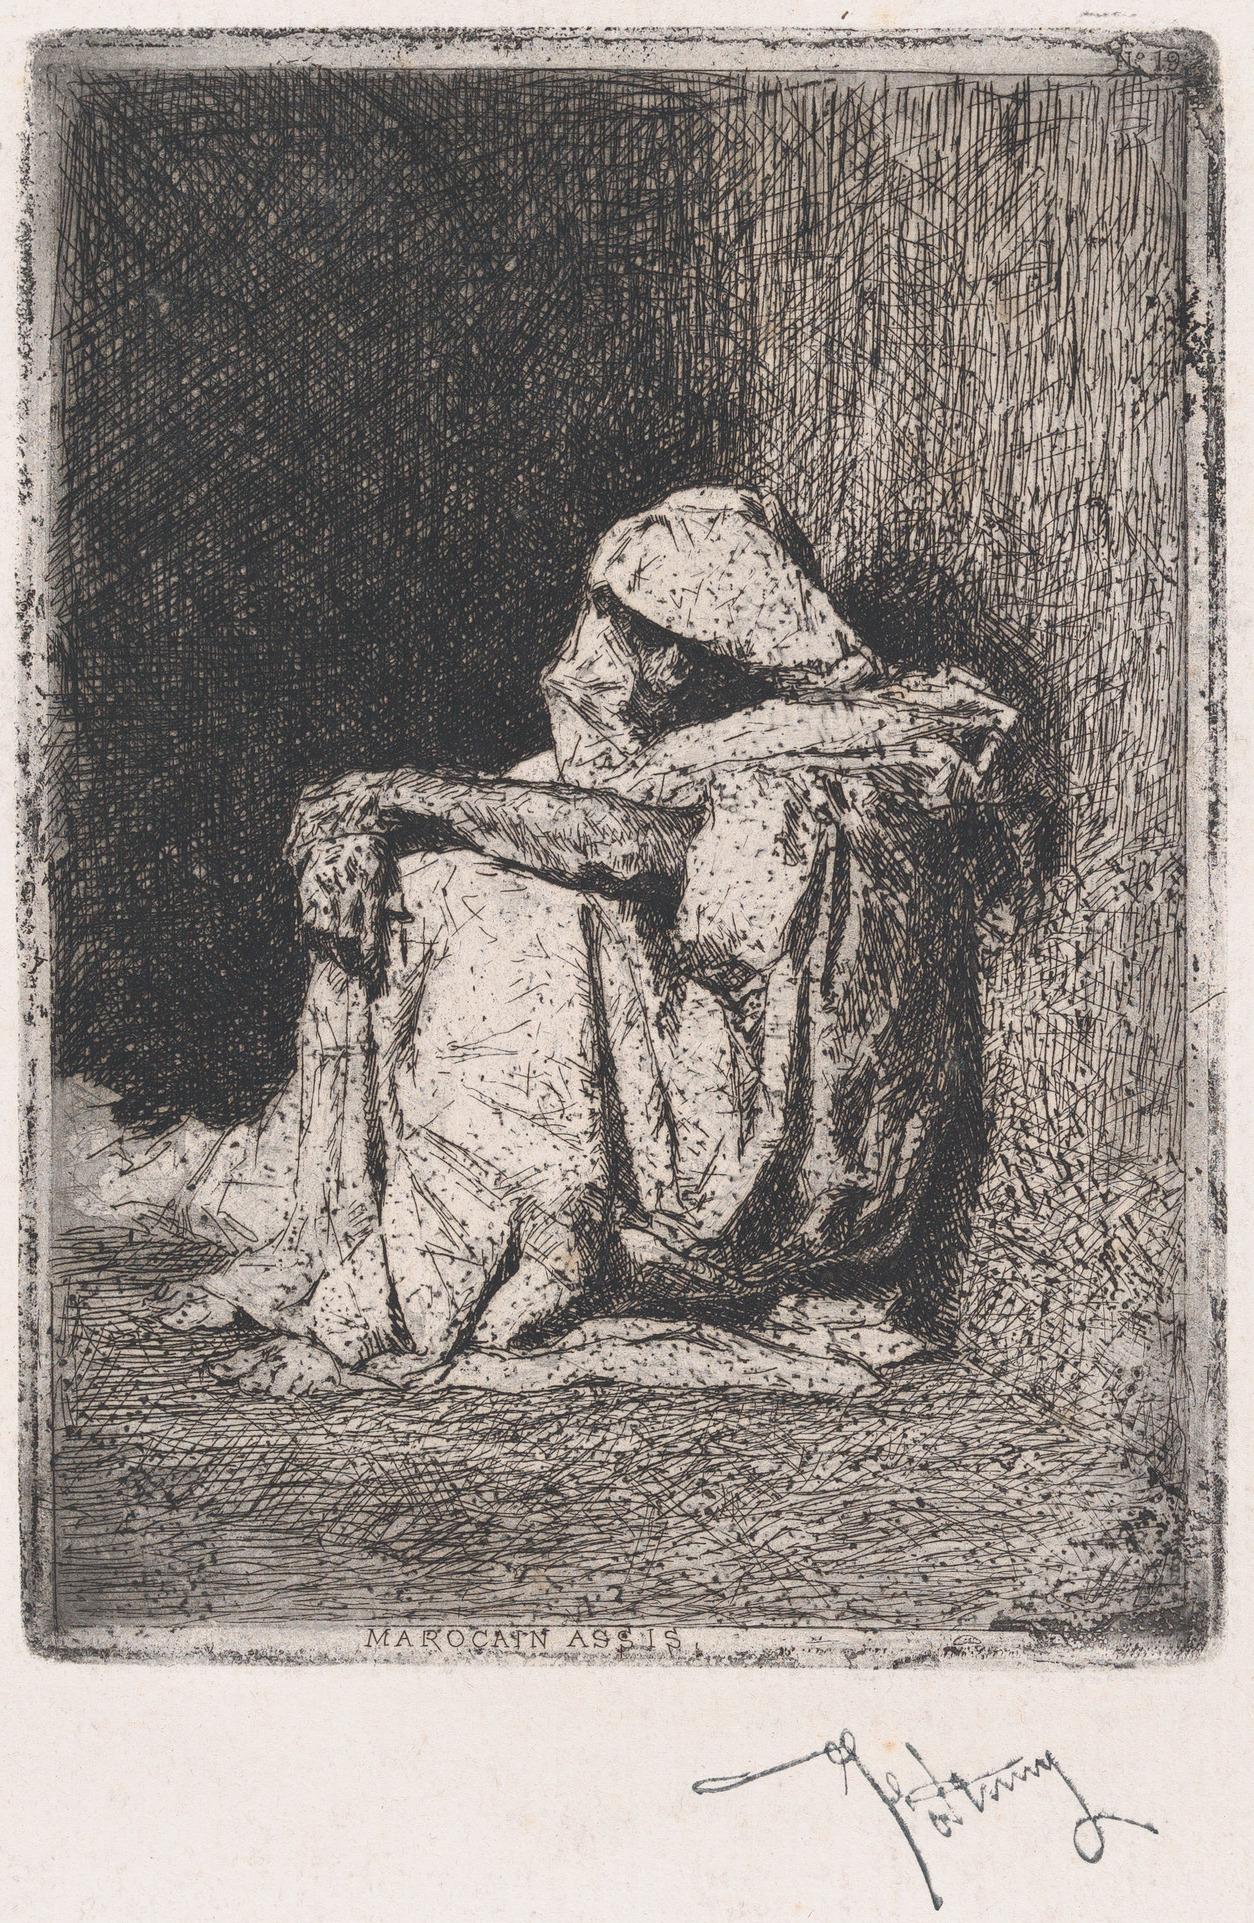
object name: print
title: A Moroccan man seated on the ground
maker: mariano fortuny, 1838–1874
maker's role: artist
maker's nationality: spanish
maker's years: 1838-1874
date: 1860-1870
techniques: etching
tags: men